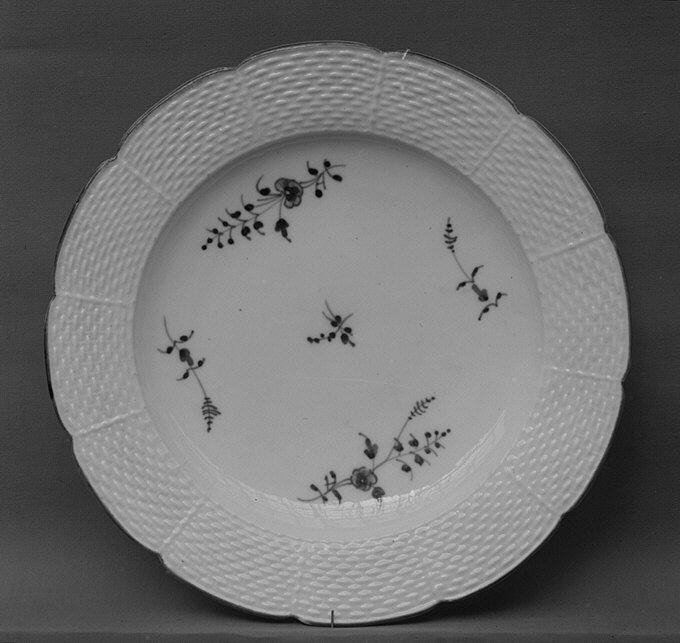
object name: plate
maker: chantilly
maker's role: factory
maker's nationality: french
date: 1770-1775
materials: soft paste porcelain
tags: flowers